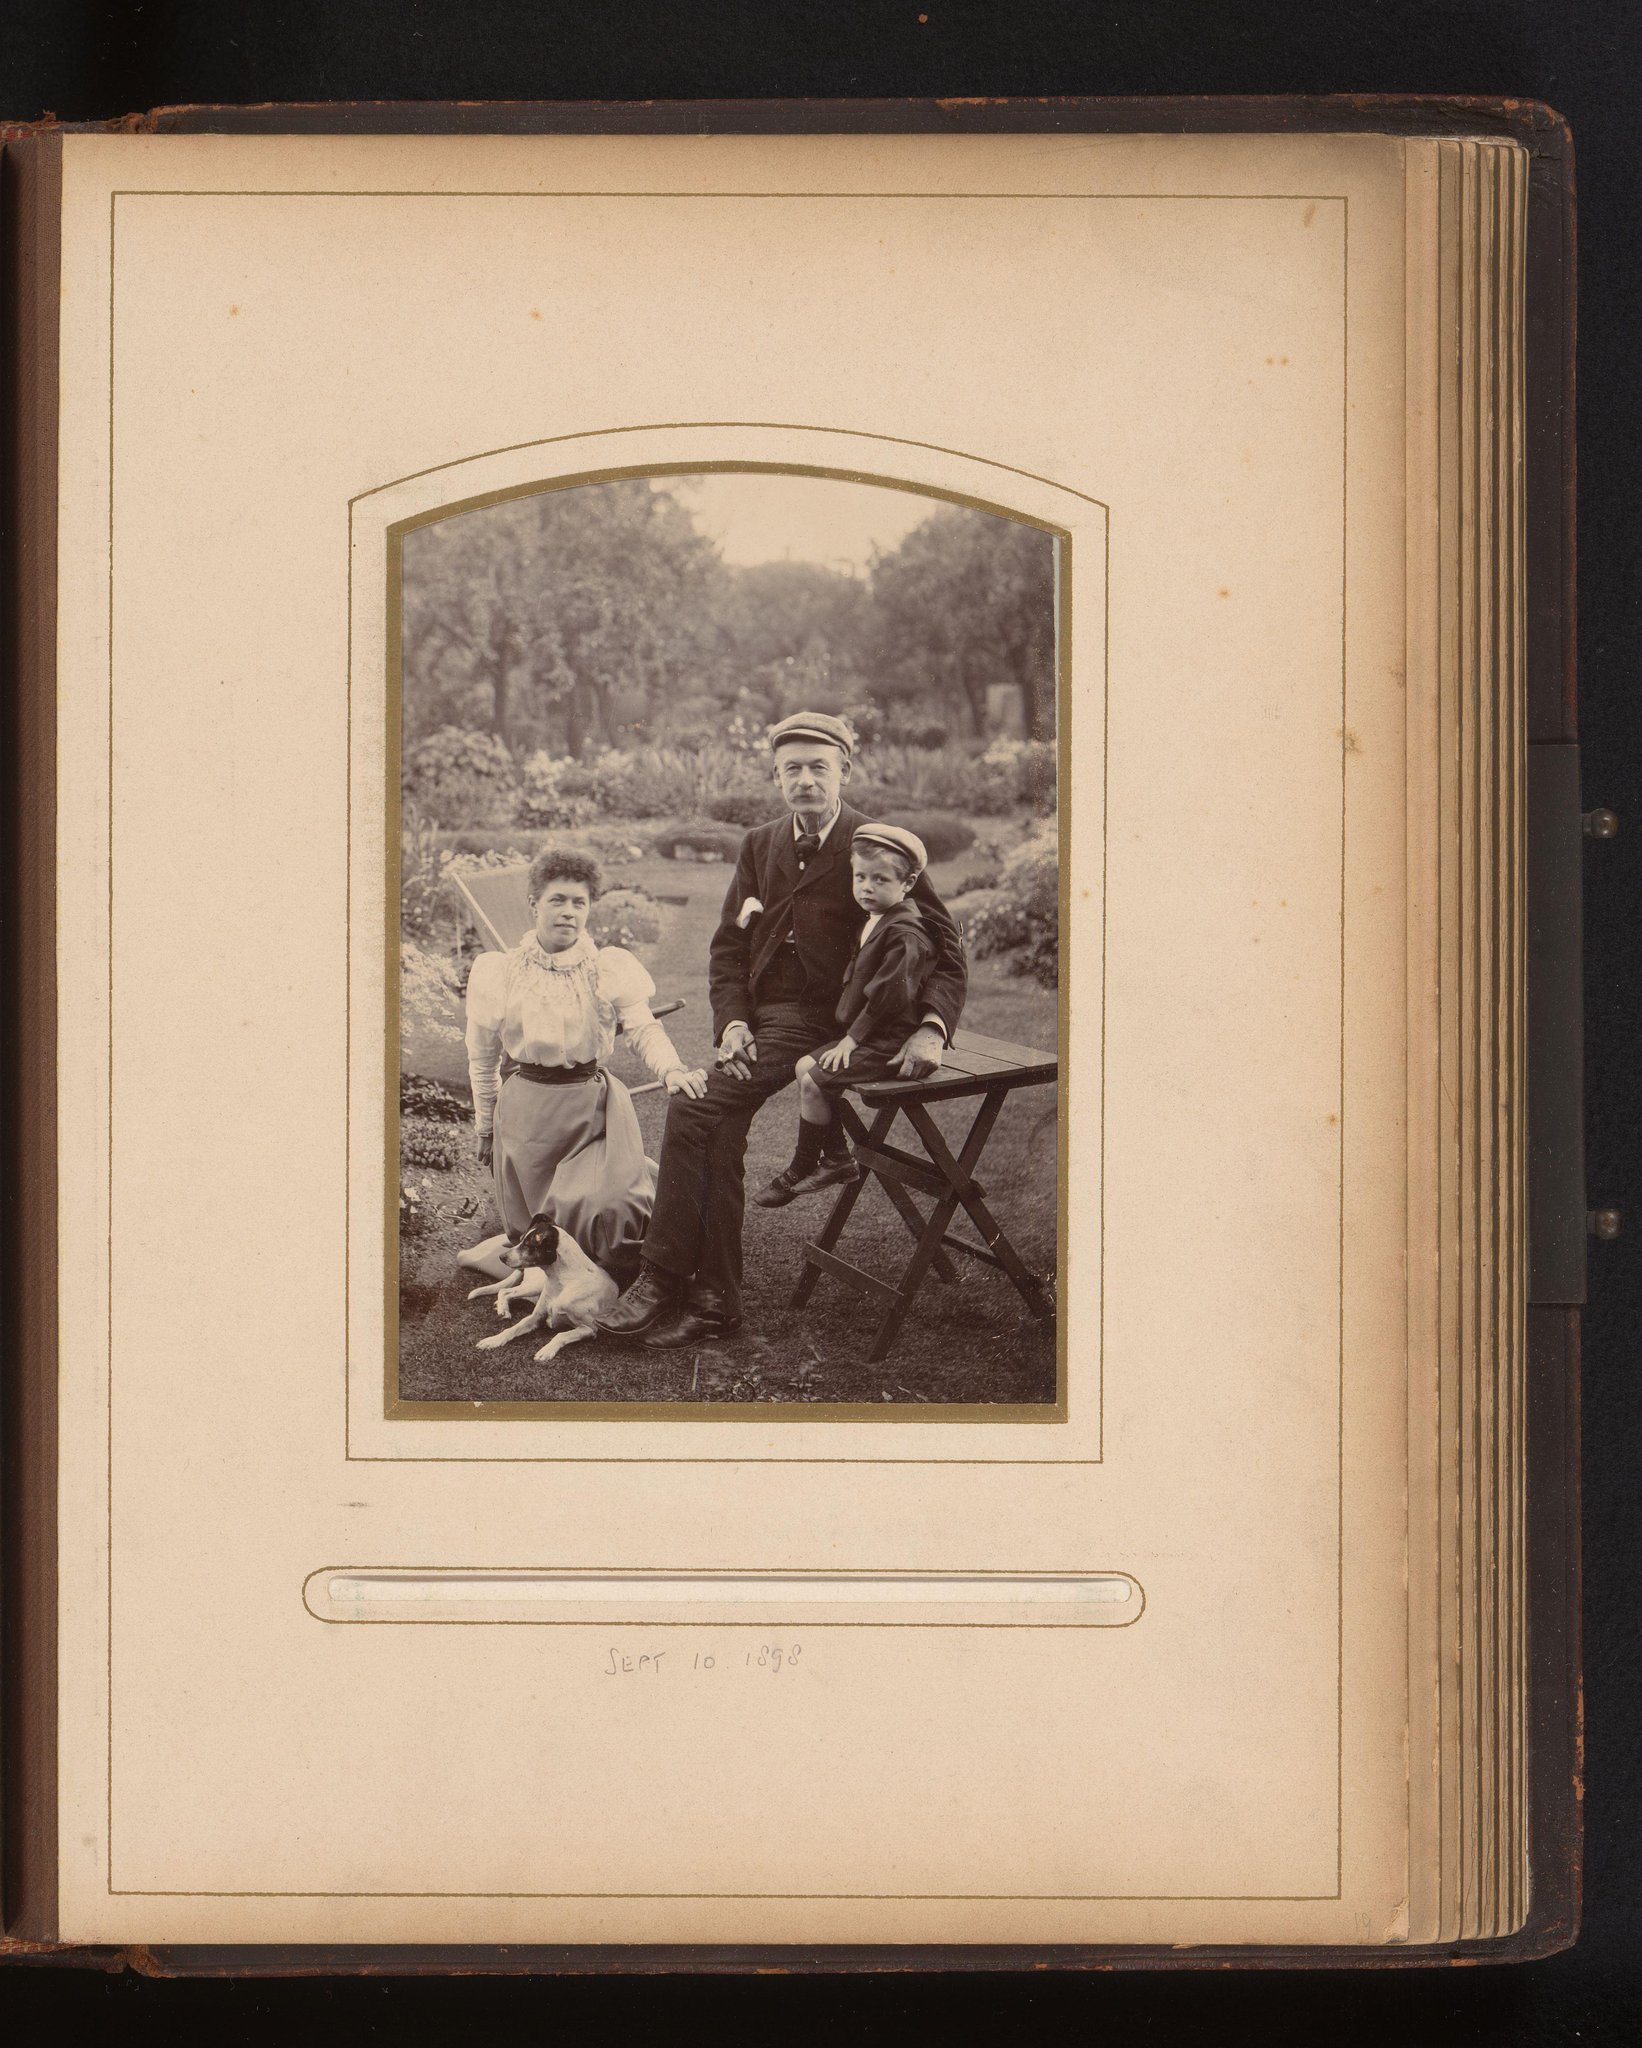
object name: album leaf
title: Familieportret in een tuin of park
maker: c. eden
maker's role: fotograaf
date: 1898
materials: cardboard, photographic support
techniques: collodion silver print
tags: trees, parents with their children, historical persons, dog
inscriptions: inscription: ‘Photographic artist/ C. Eden/ Sandringham Studio/ 35, High Street/ Ealing’, annotation: ‘Sept 10/98’